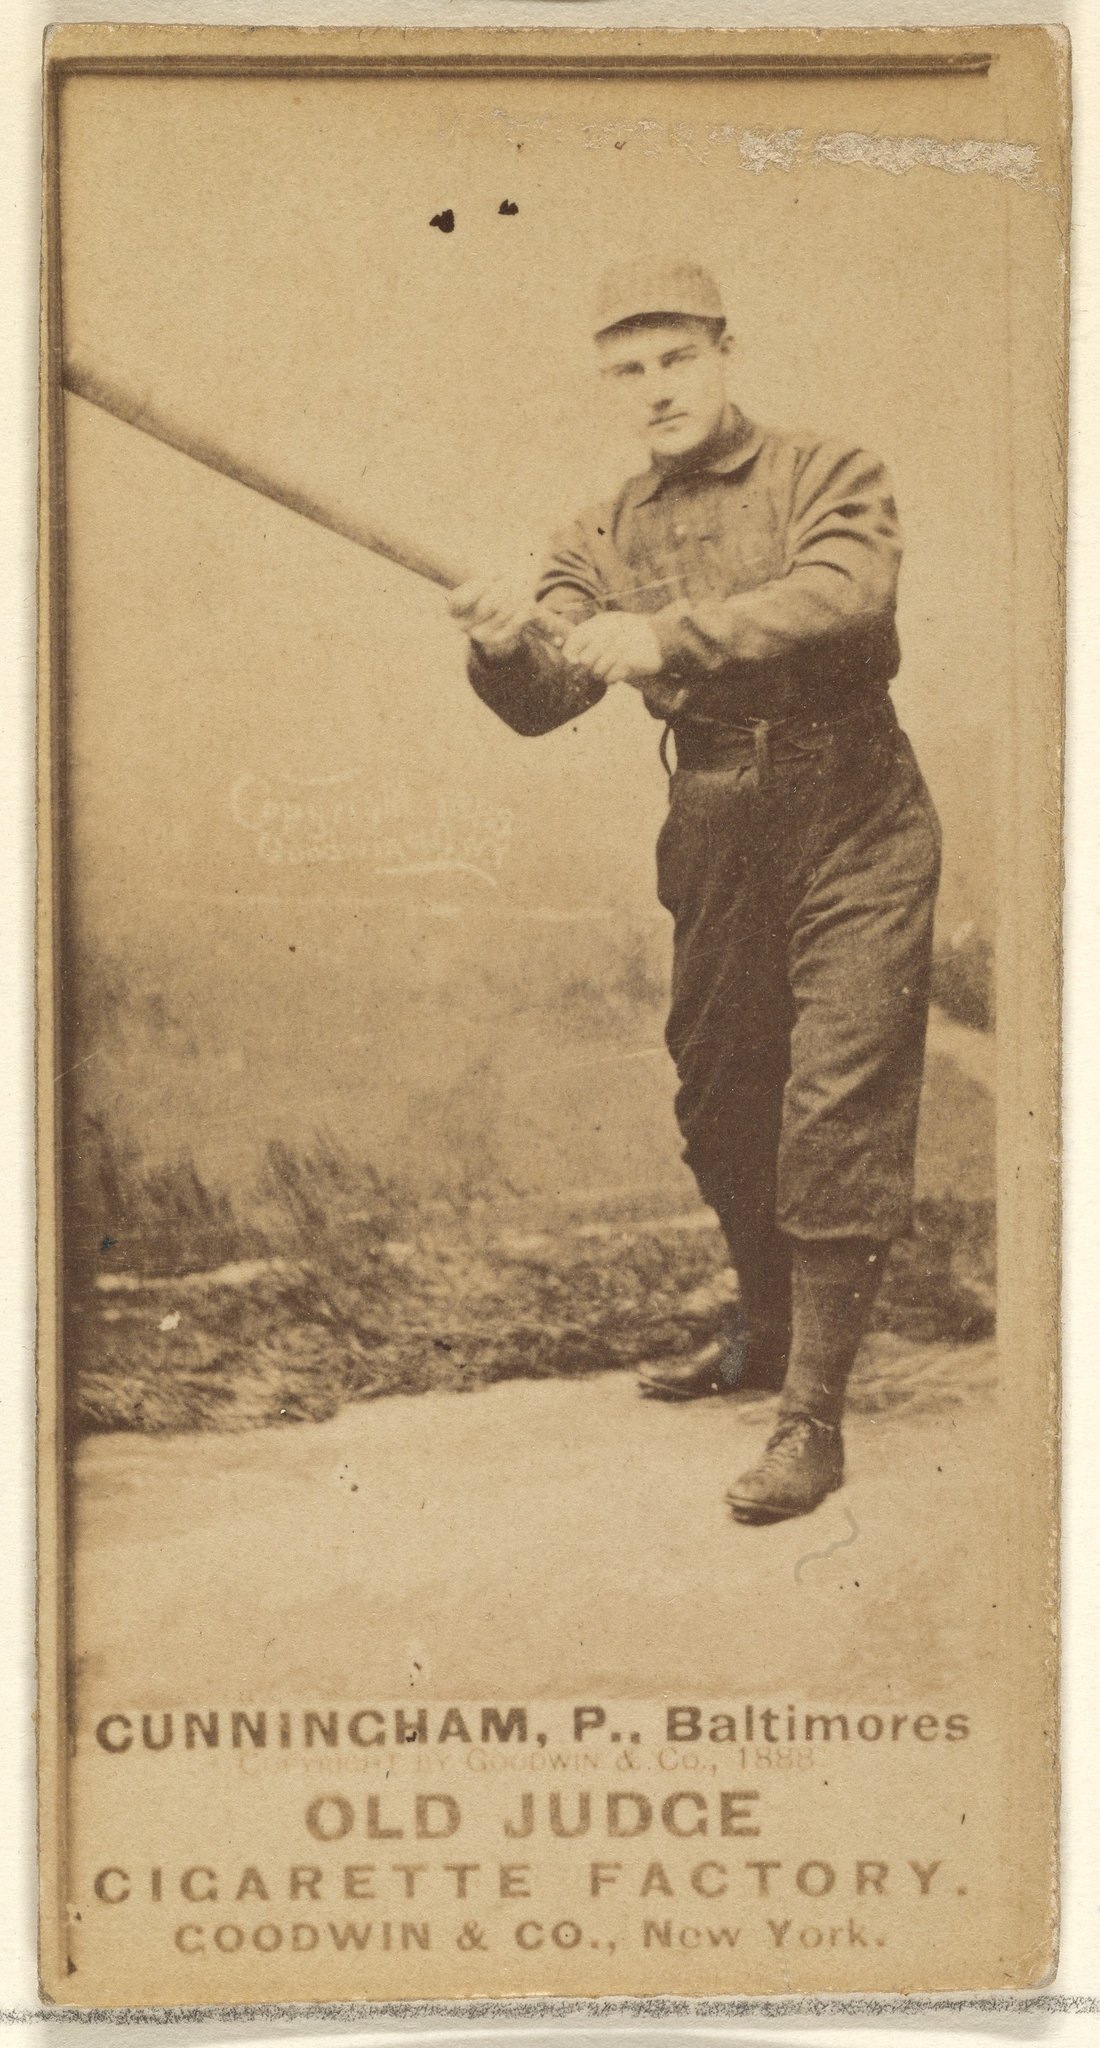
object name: baseball card, photograph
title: Cunningham, Pitcher, Baltimore Orioles, from the Old Judge series (N172) for Old Judge Cigarettes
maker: goodwin & company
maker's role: publisher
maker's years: 1850-1950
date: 1888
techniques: albumen silver print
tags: men,portraits,baseball,athletes